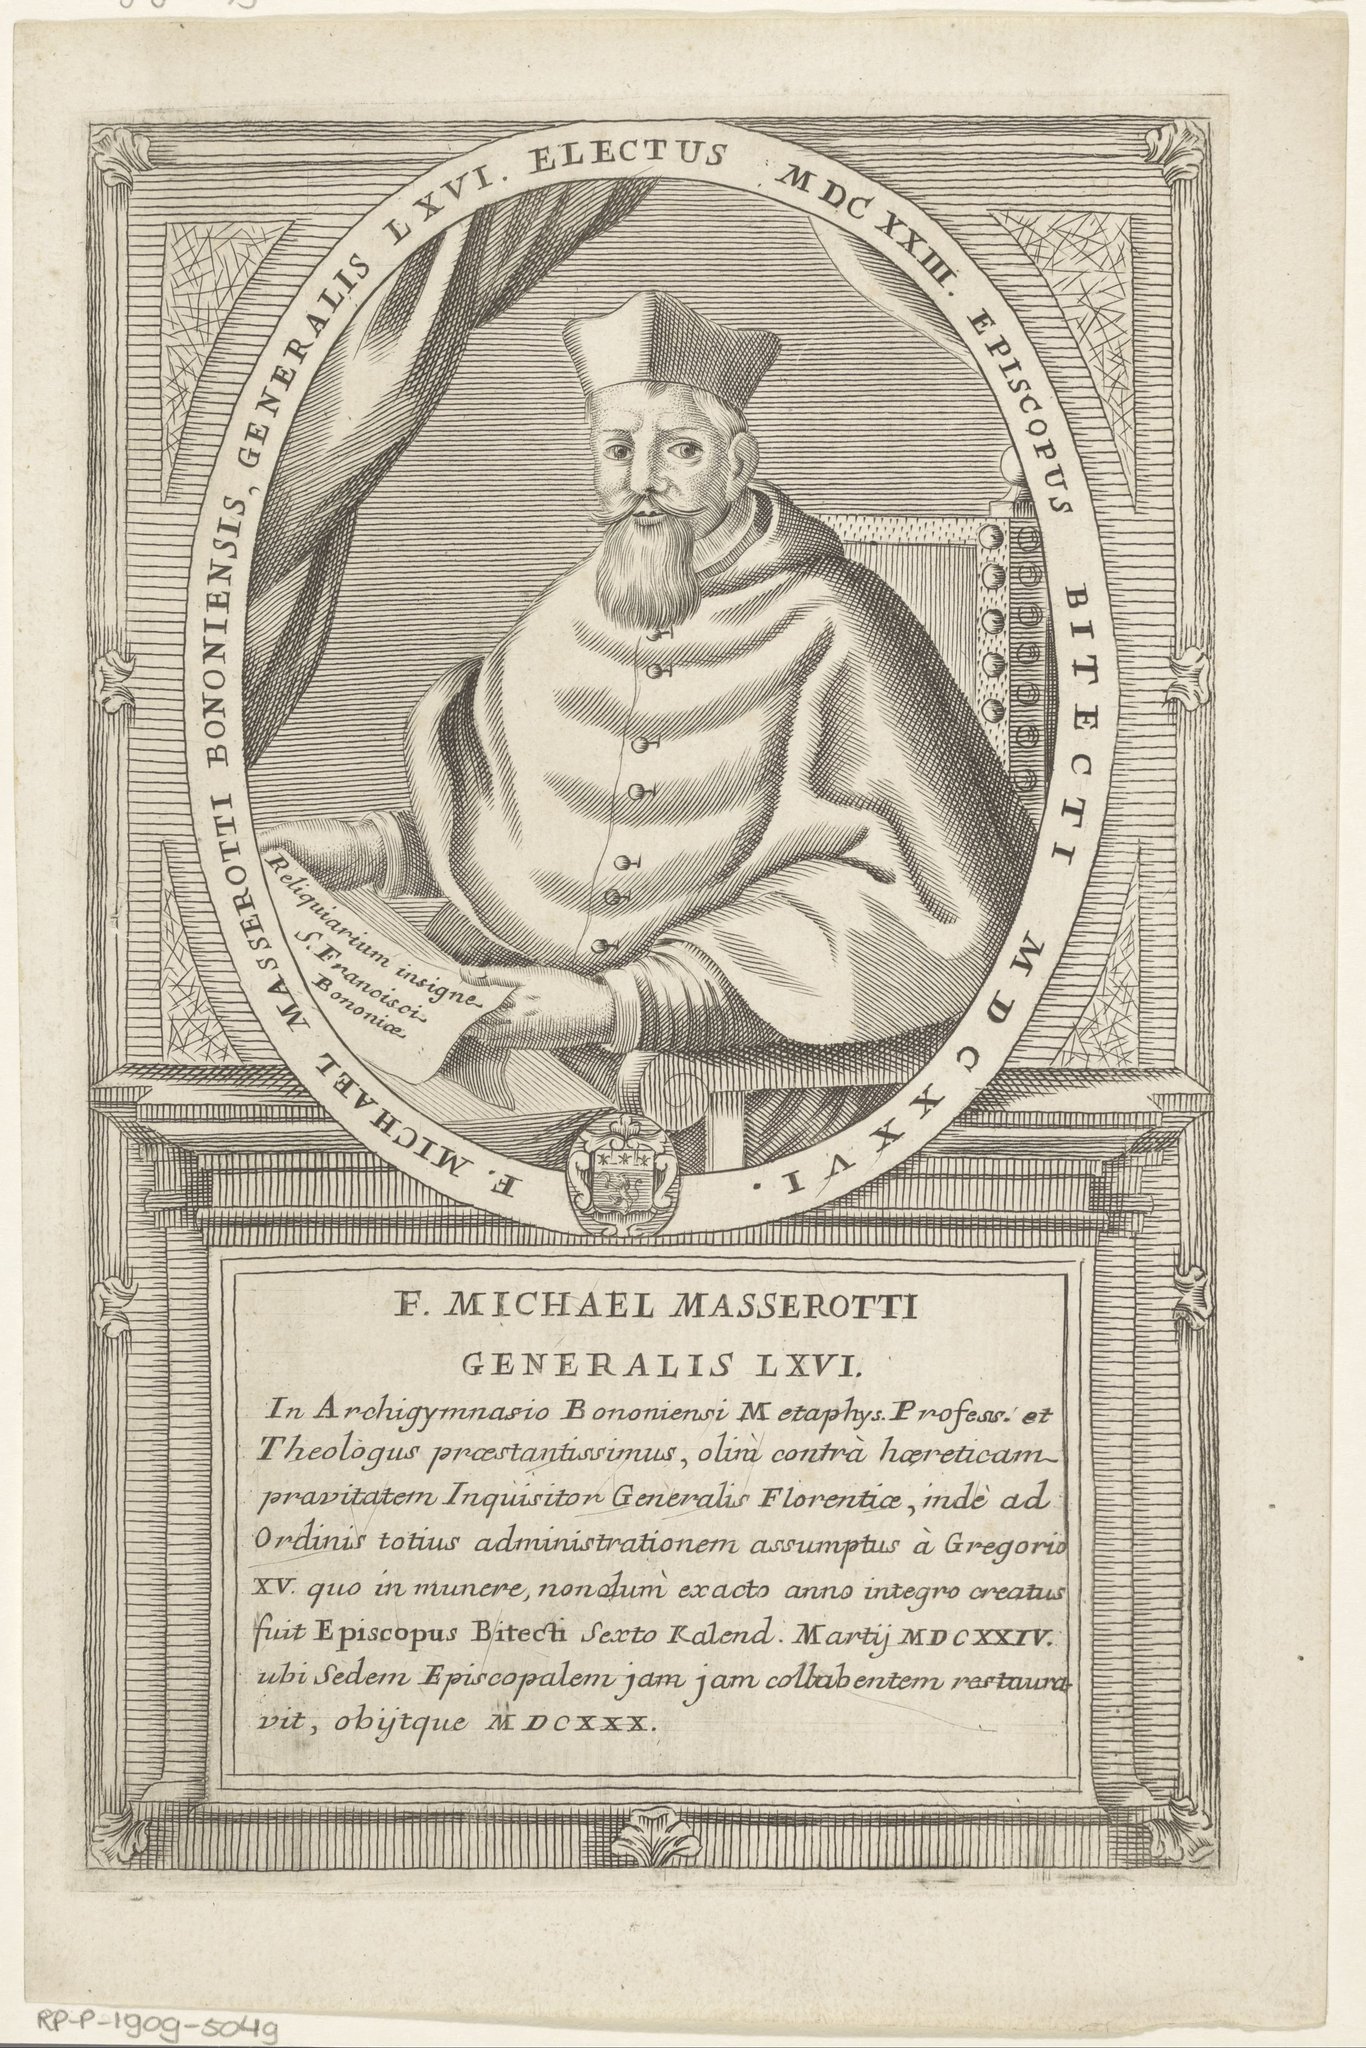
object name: print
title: Portretten van Ministers Generaal van de franciscaner orde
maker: antonio luciani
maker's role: print maker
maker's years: 1700-1738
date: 1710-1738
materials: paper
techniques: engraving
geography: italy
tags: historical persons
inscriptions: collector's mark: Lugt 2228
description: Deze prent maakt deel uit van een groep van 60 portretten.